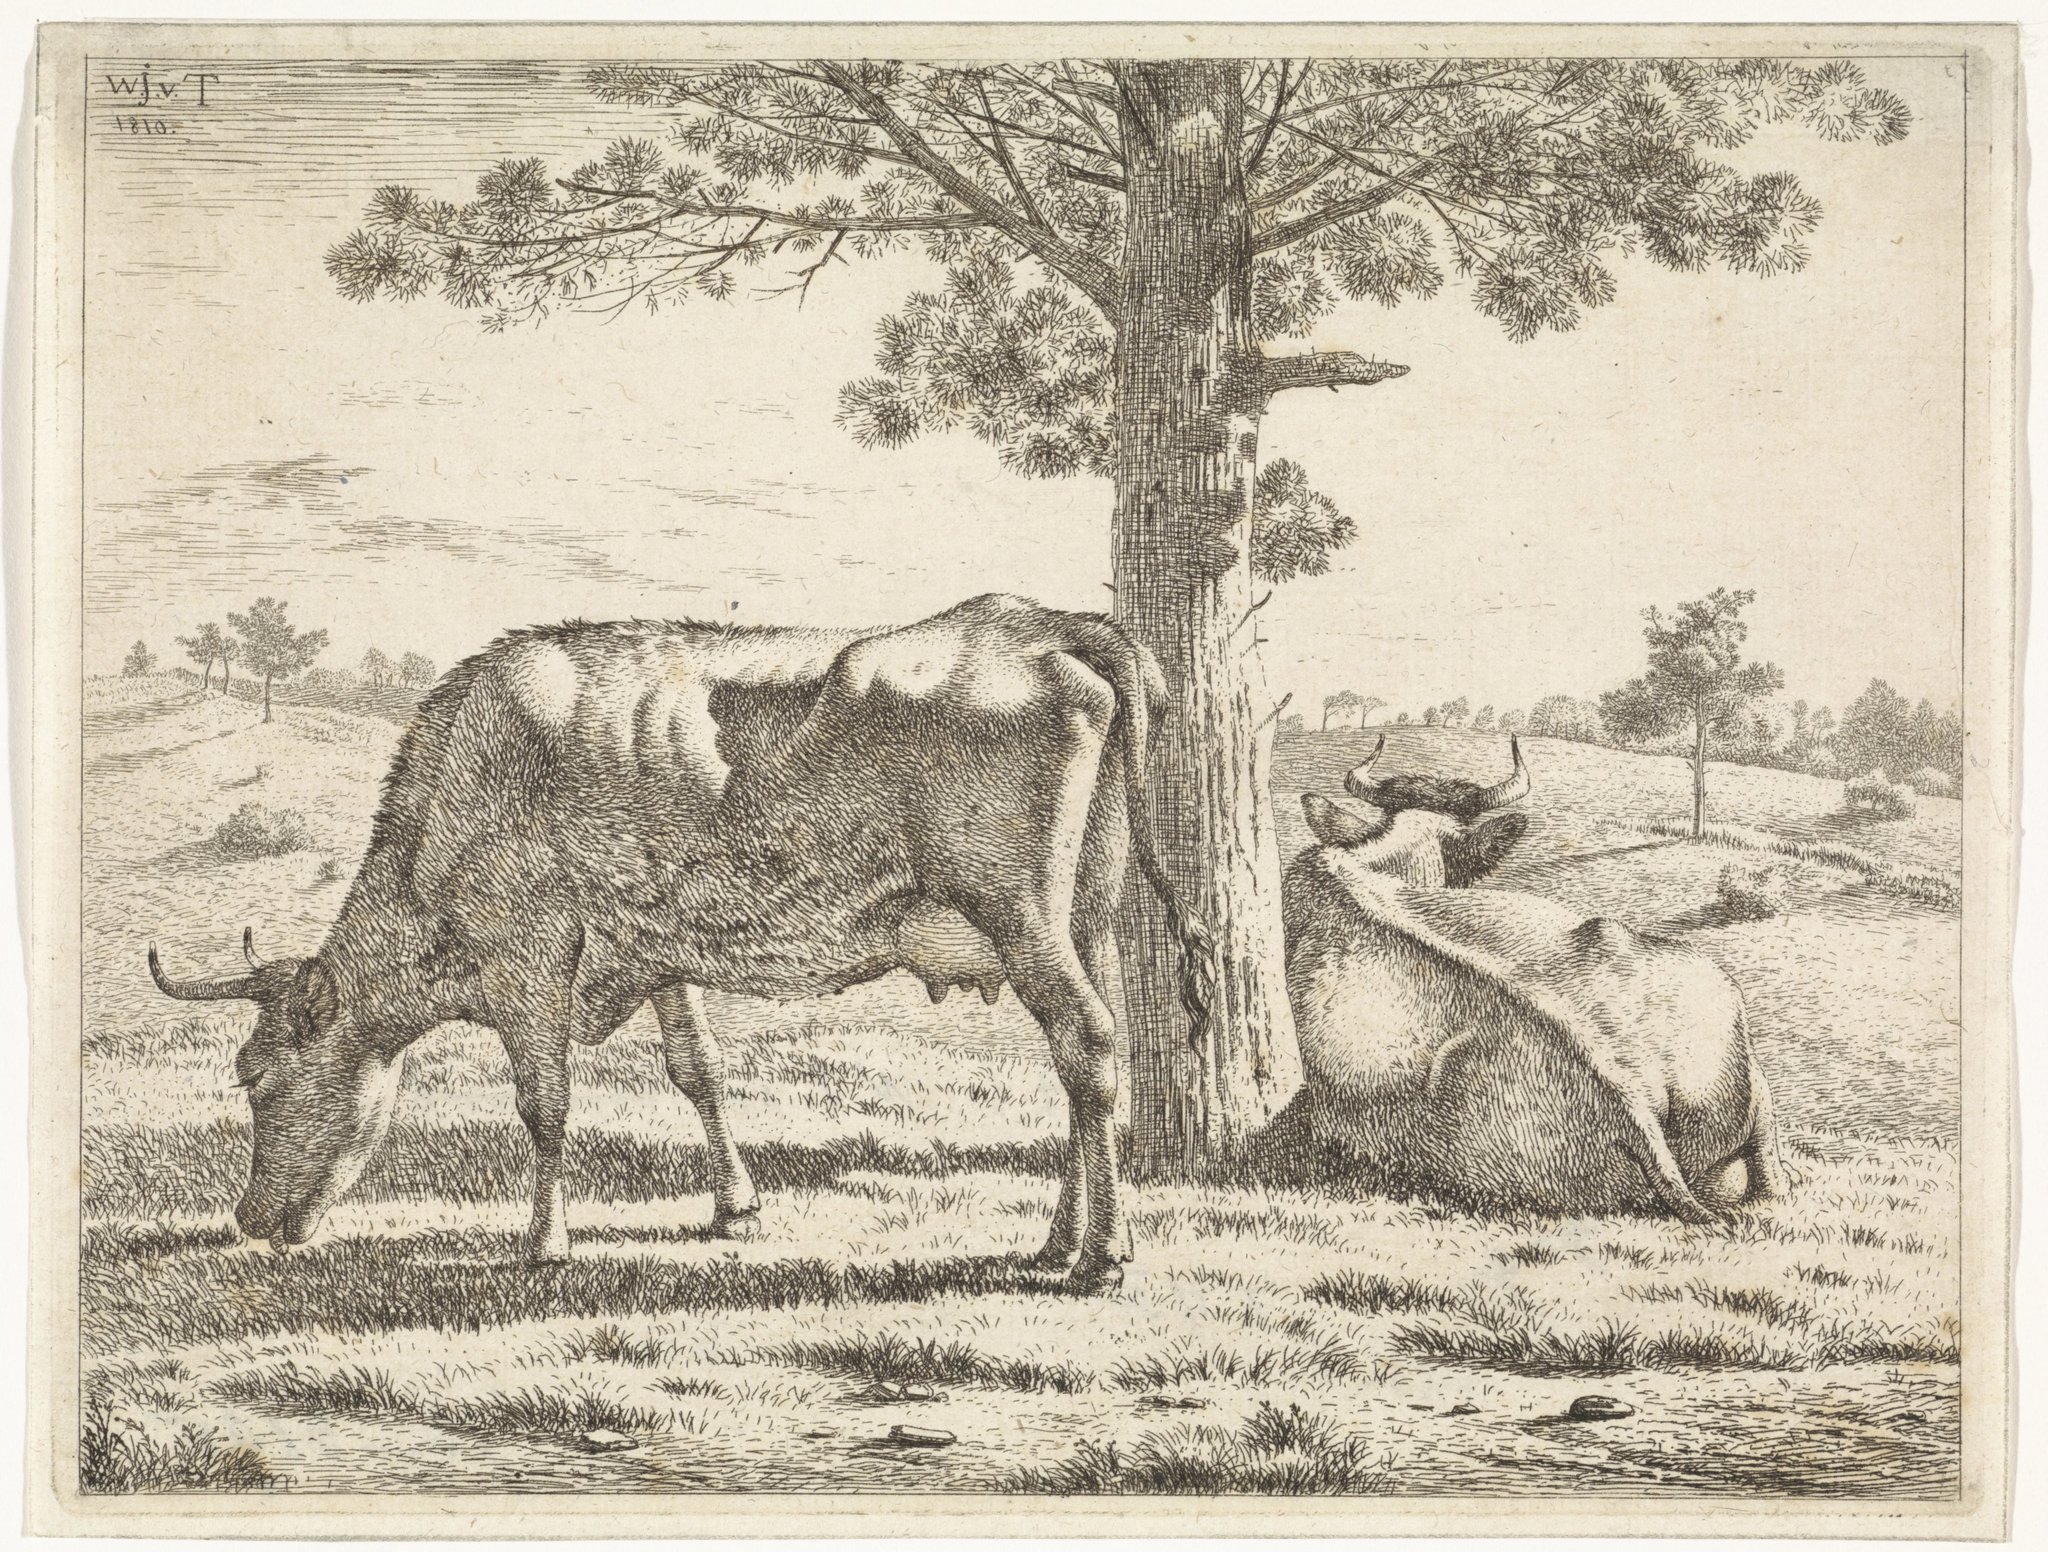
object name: print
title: Twee koeien bij een boom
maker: wouter johannes van troostwijk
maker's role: draughtsman, painter, print maker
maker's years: 1782-1810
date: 1810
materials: paper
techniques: etching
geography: amsterdam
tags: cow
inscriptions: date